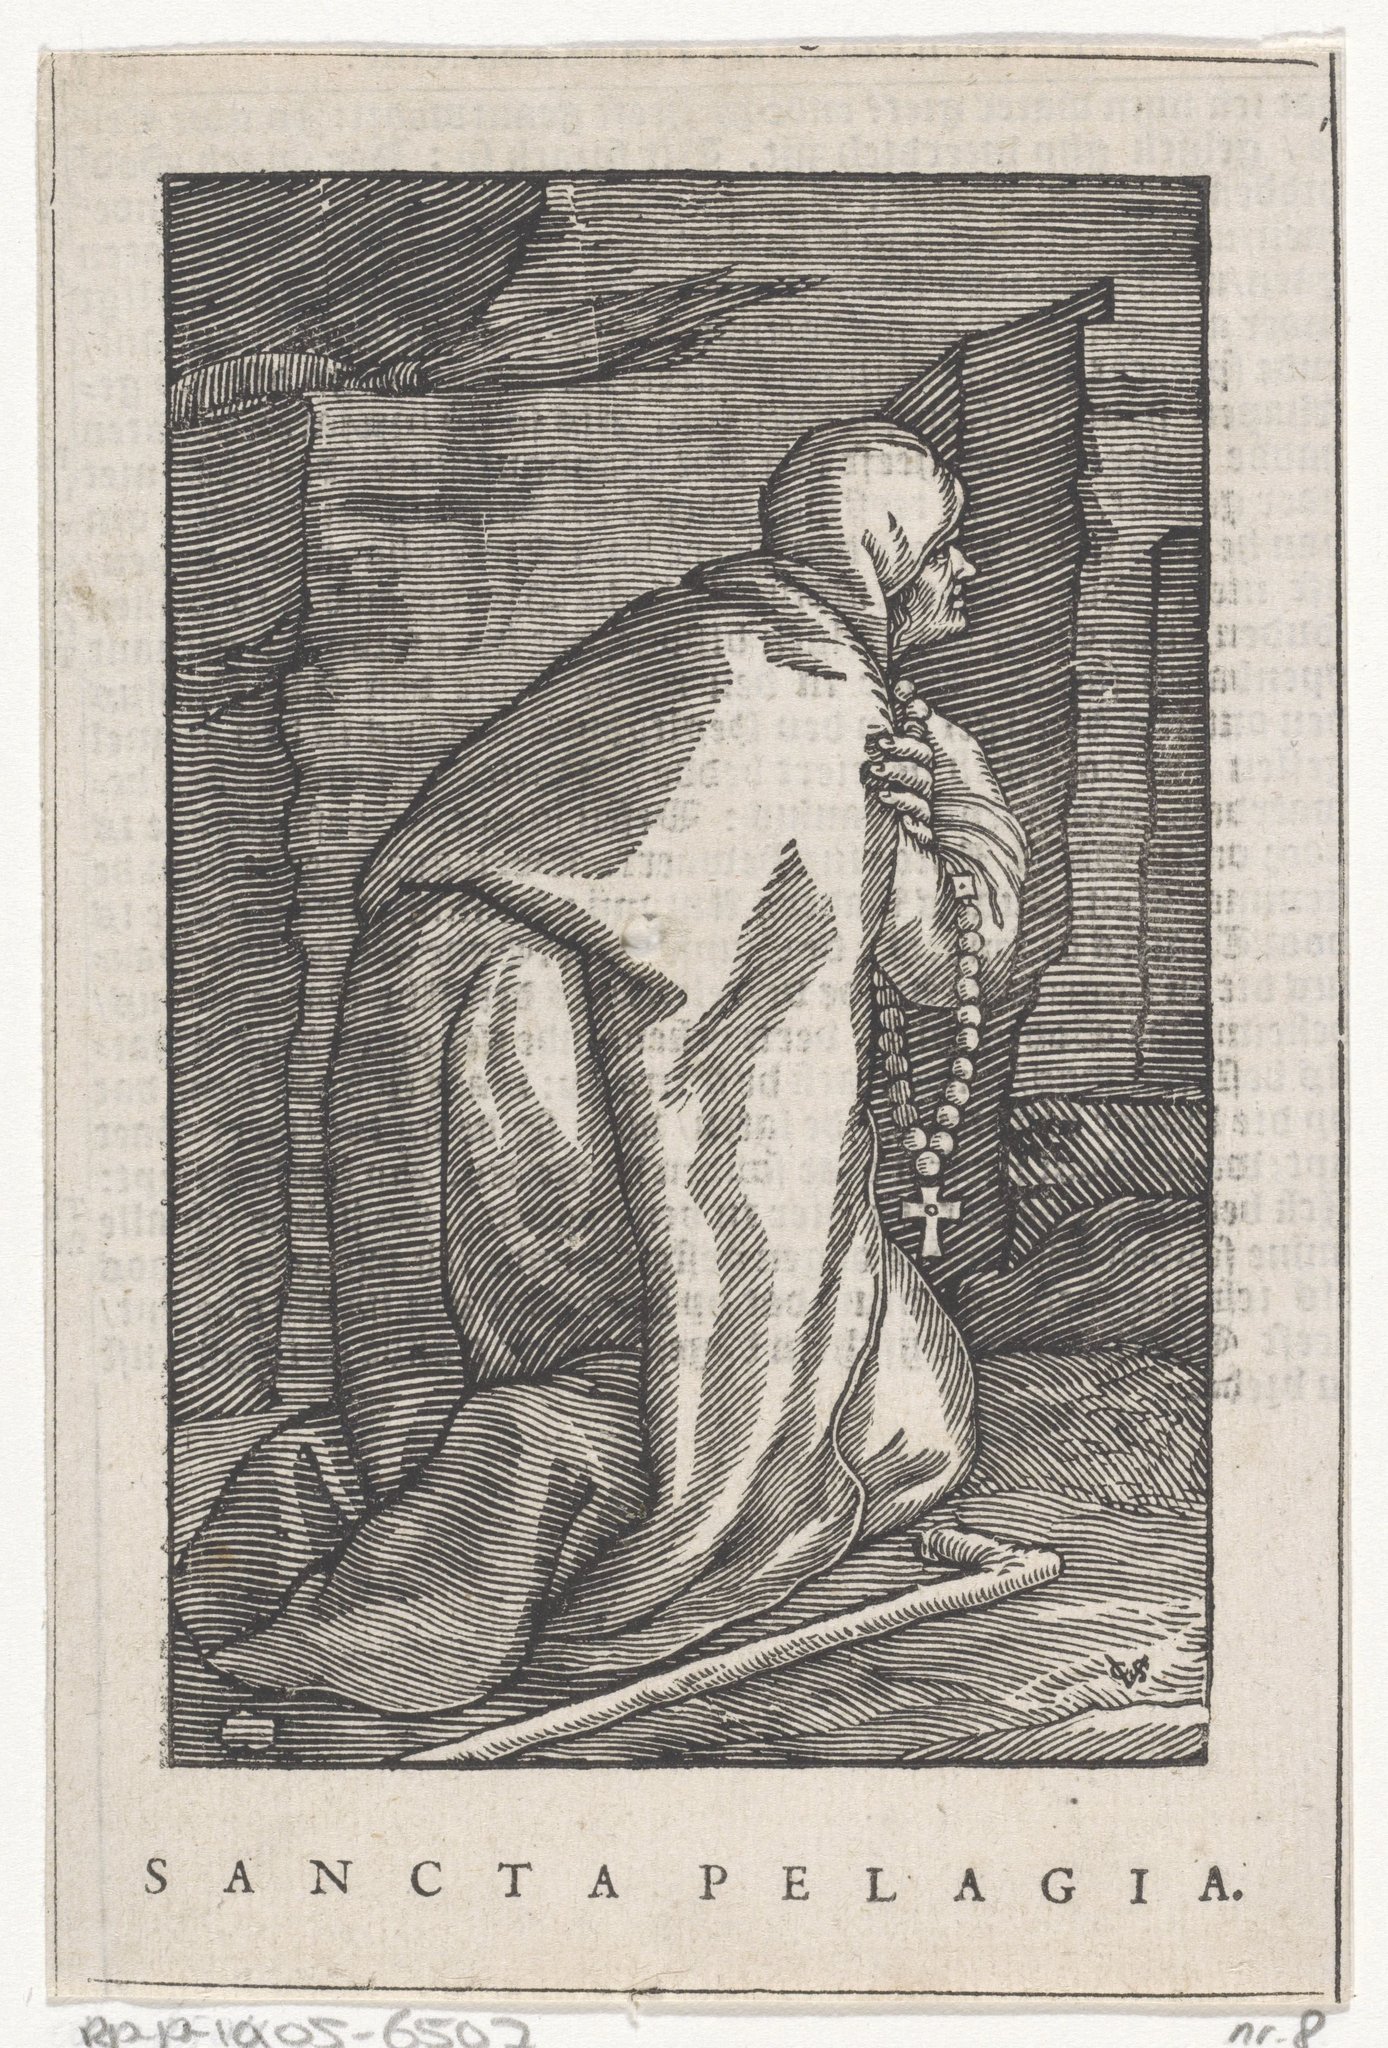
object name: print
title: Heilige Pelagia van Antiochië als kluizenares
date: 1644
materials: paper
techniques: letterpress printing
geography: amsterdam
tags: anchorite, hermit, female saints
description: Prent uit: Rosweyde, Heribert. 'tBosch der eremyten ende eremitinnen, van Aegypten ende Palestinen. Amsterdam: Pieter Jacobsz. Paets, 1644.